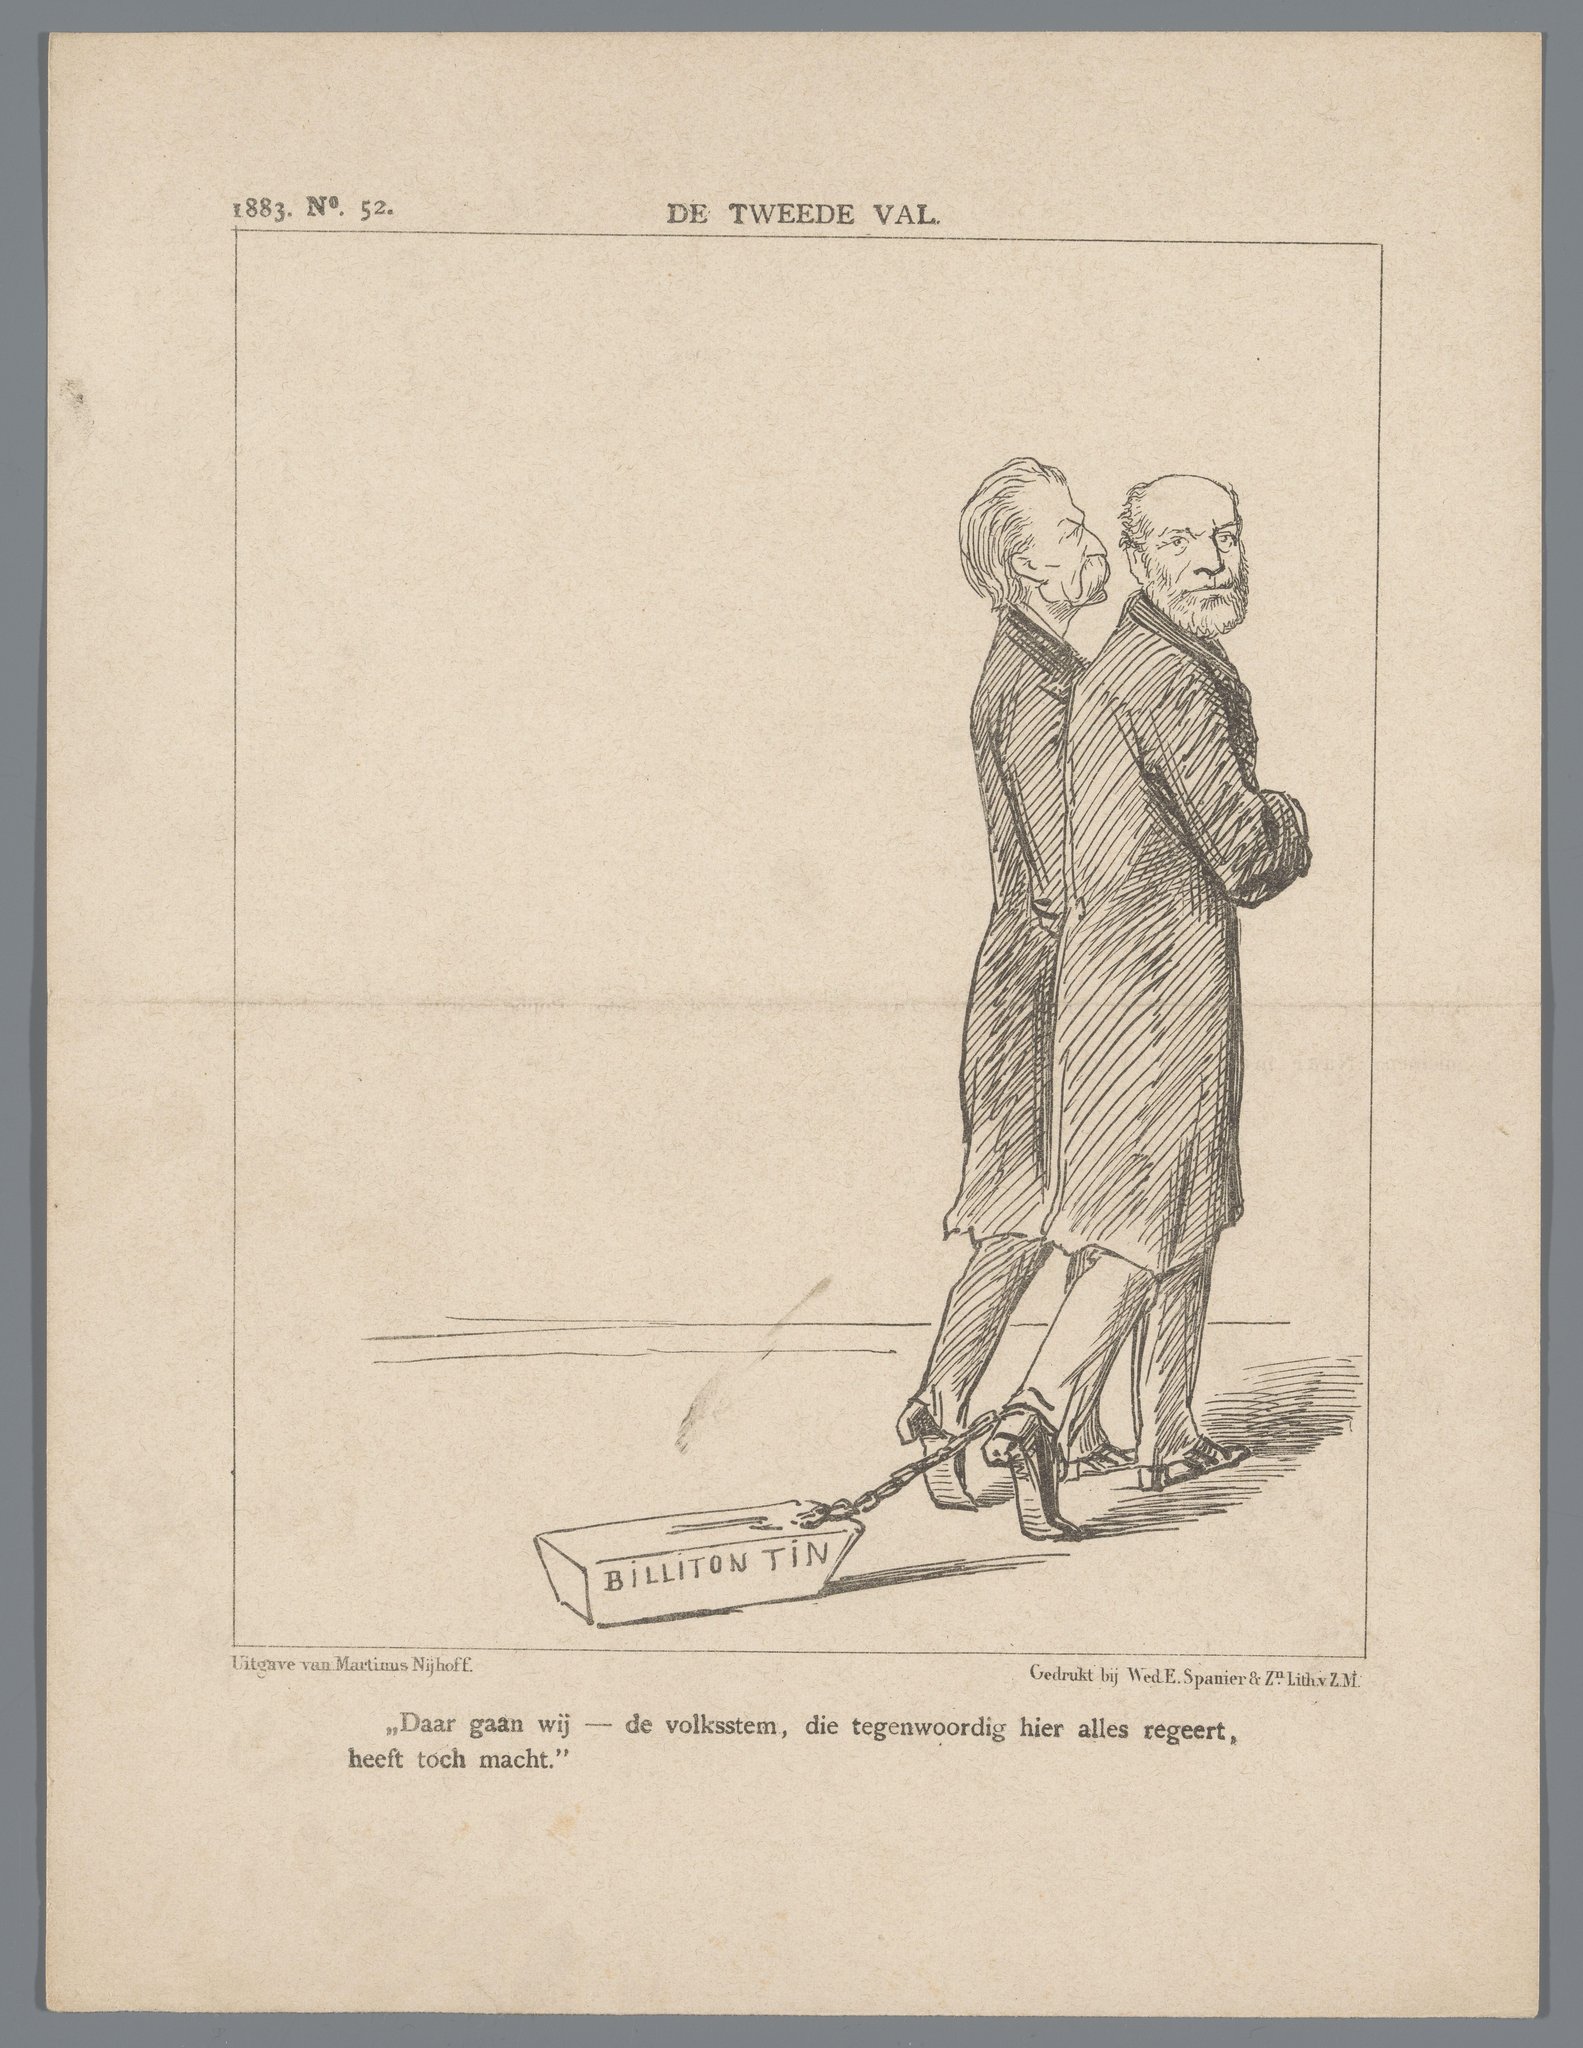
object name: cartoon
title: Spotprent over de politieke nasleep van het Billiton-schandaal, 1883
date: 1883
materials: paper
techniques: lithograph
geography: netherlands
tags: willem maurits de brauw, minister van koloniën, françois gerard van bloemen waanders, billiton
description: Spotprent over de politieke nasleep van het Billiton-schandaal, 1883. De afgetreden Ministers van Koloniën De Brauw en Van Bloemen Waanders. Plaat verschenen bij het weekblad De Nederlandsche Spectator, nr. 52, 1883.